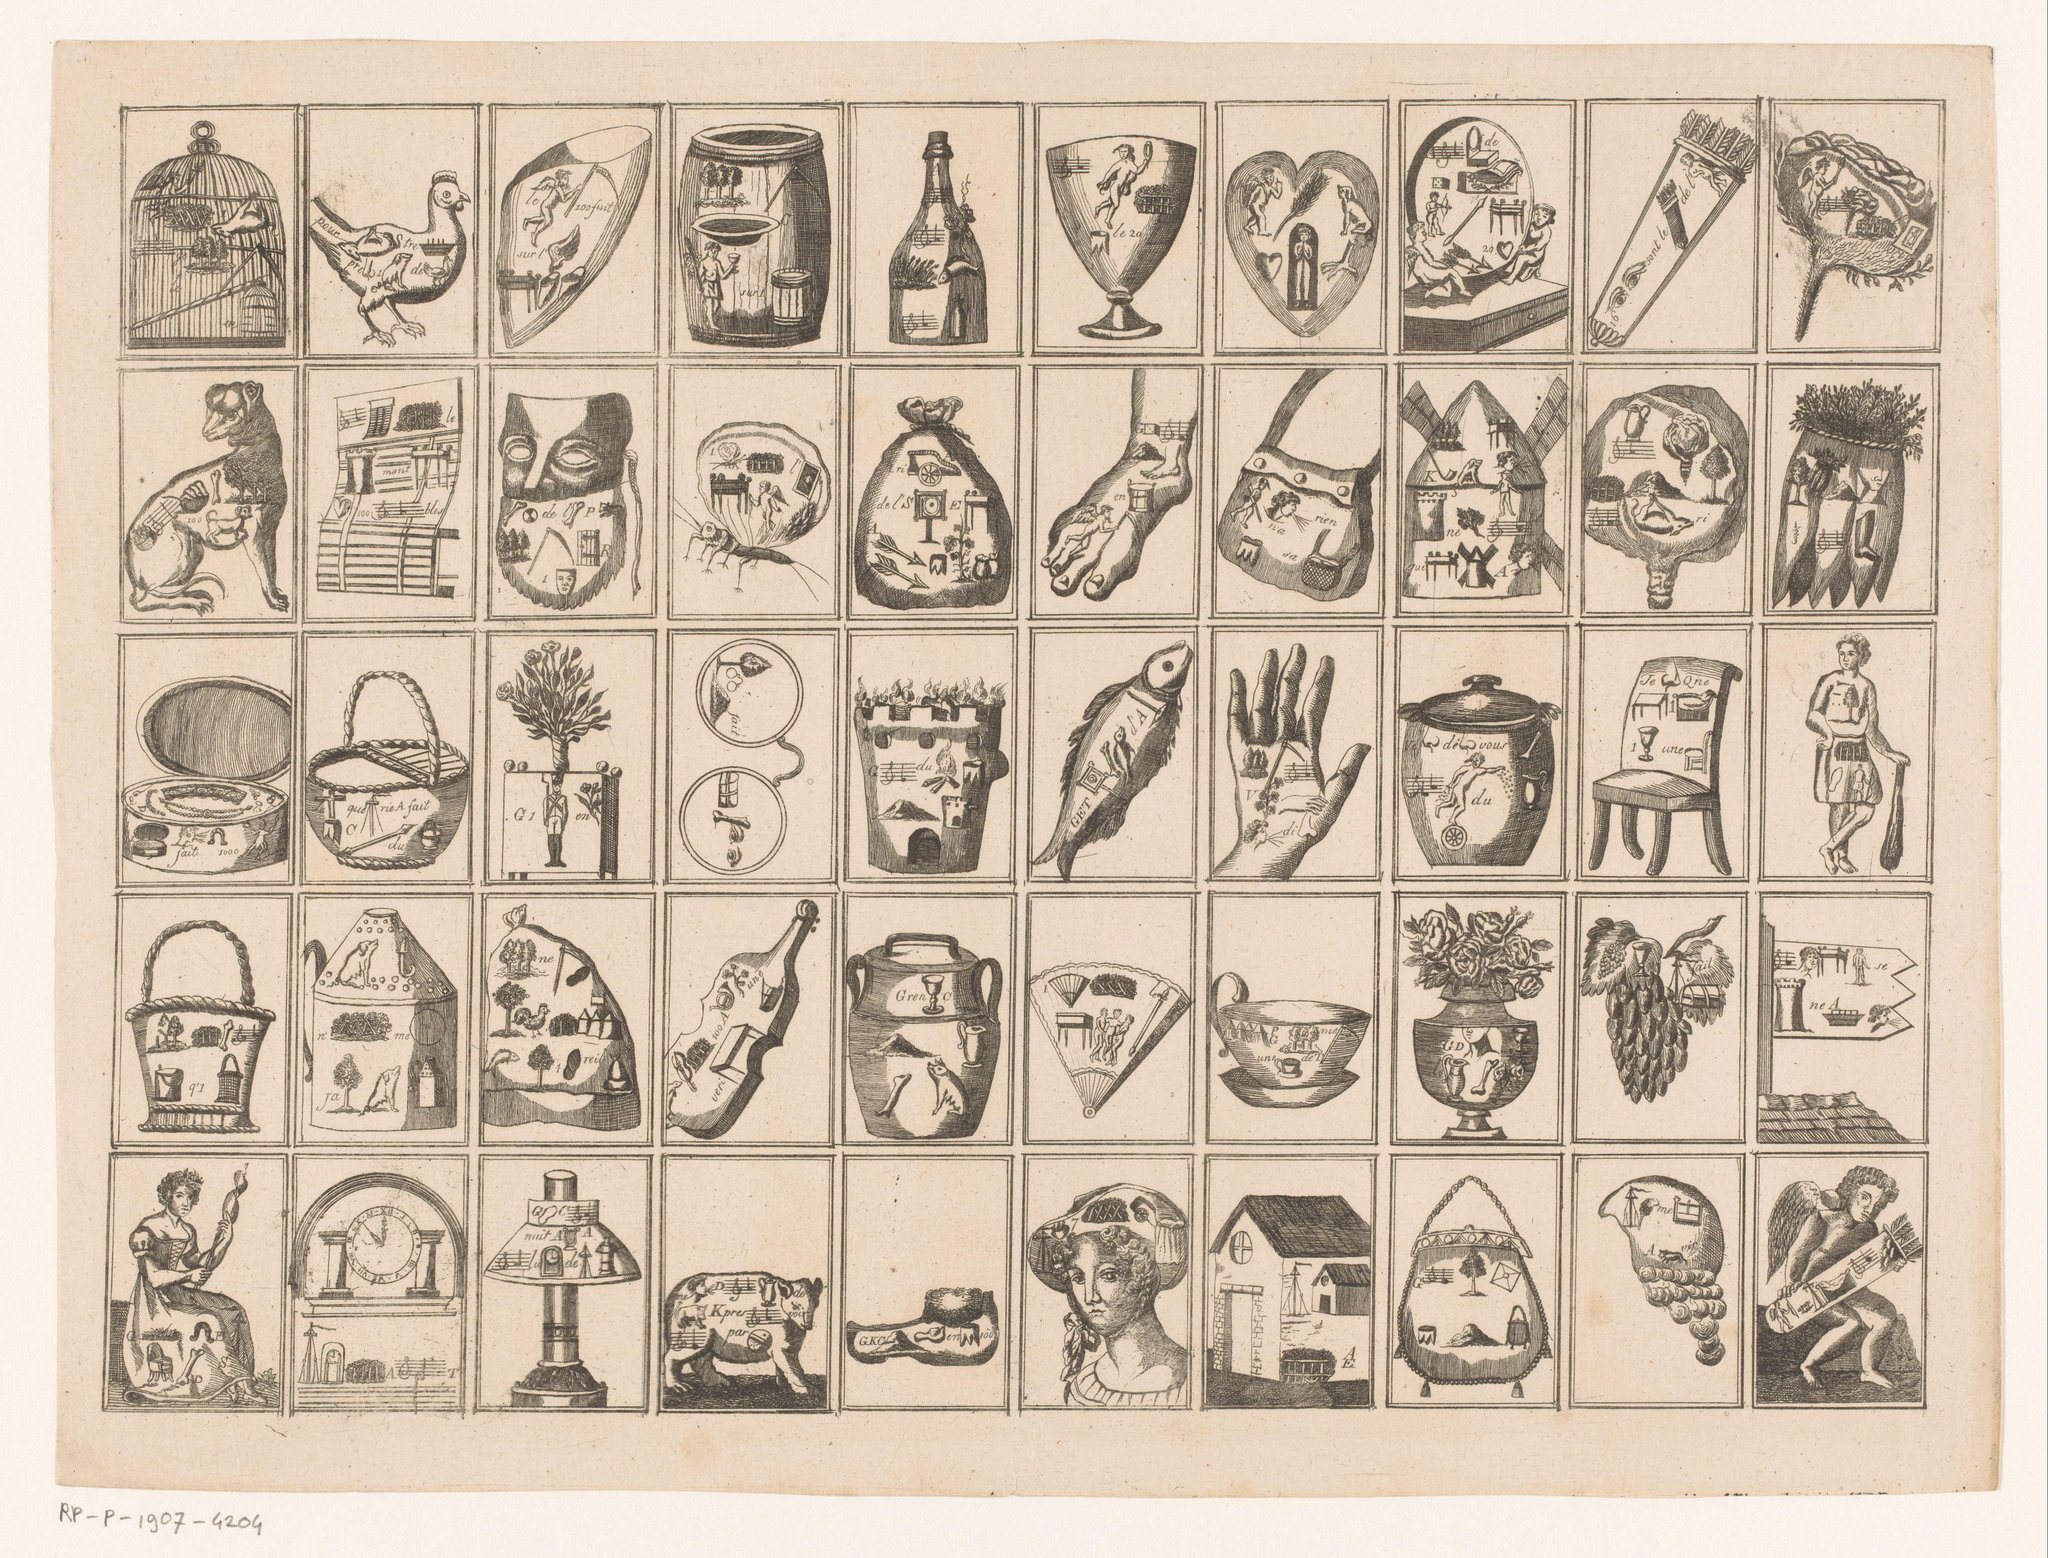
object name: print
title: Rebus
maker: Anonymous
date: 1700-1799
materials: paper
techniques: etching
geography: france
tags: rebus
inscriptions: collector's mark: Lugt 2228, watermark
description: Rebus bestaande uit 50 delen op één blad.